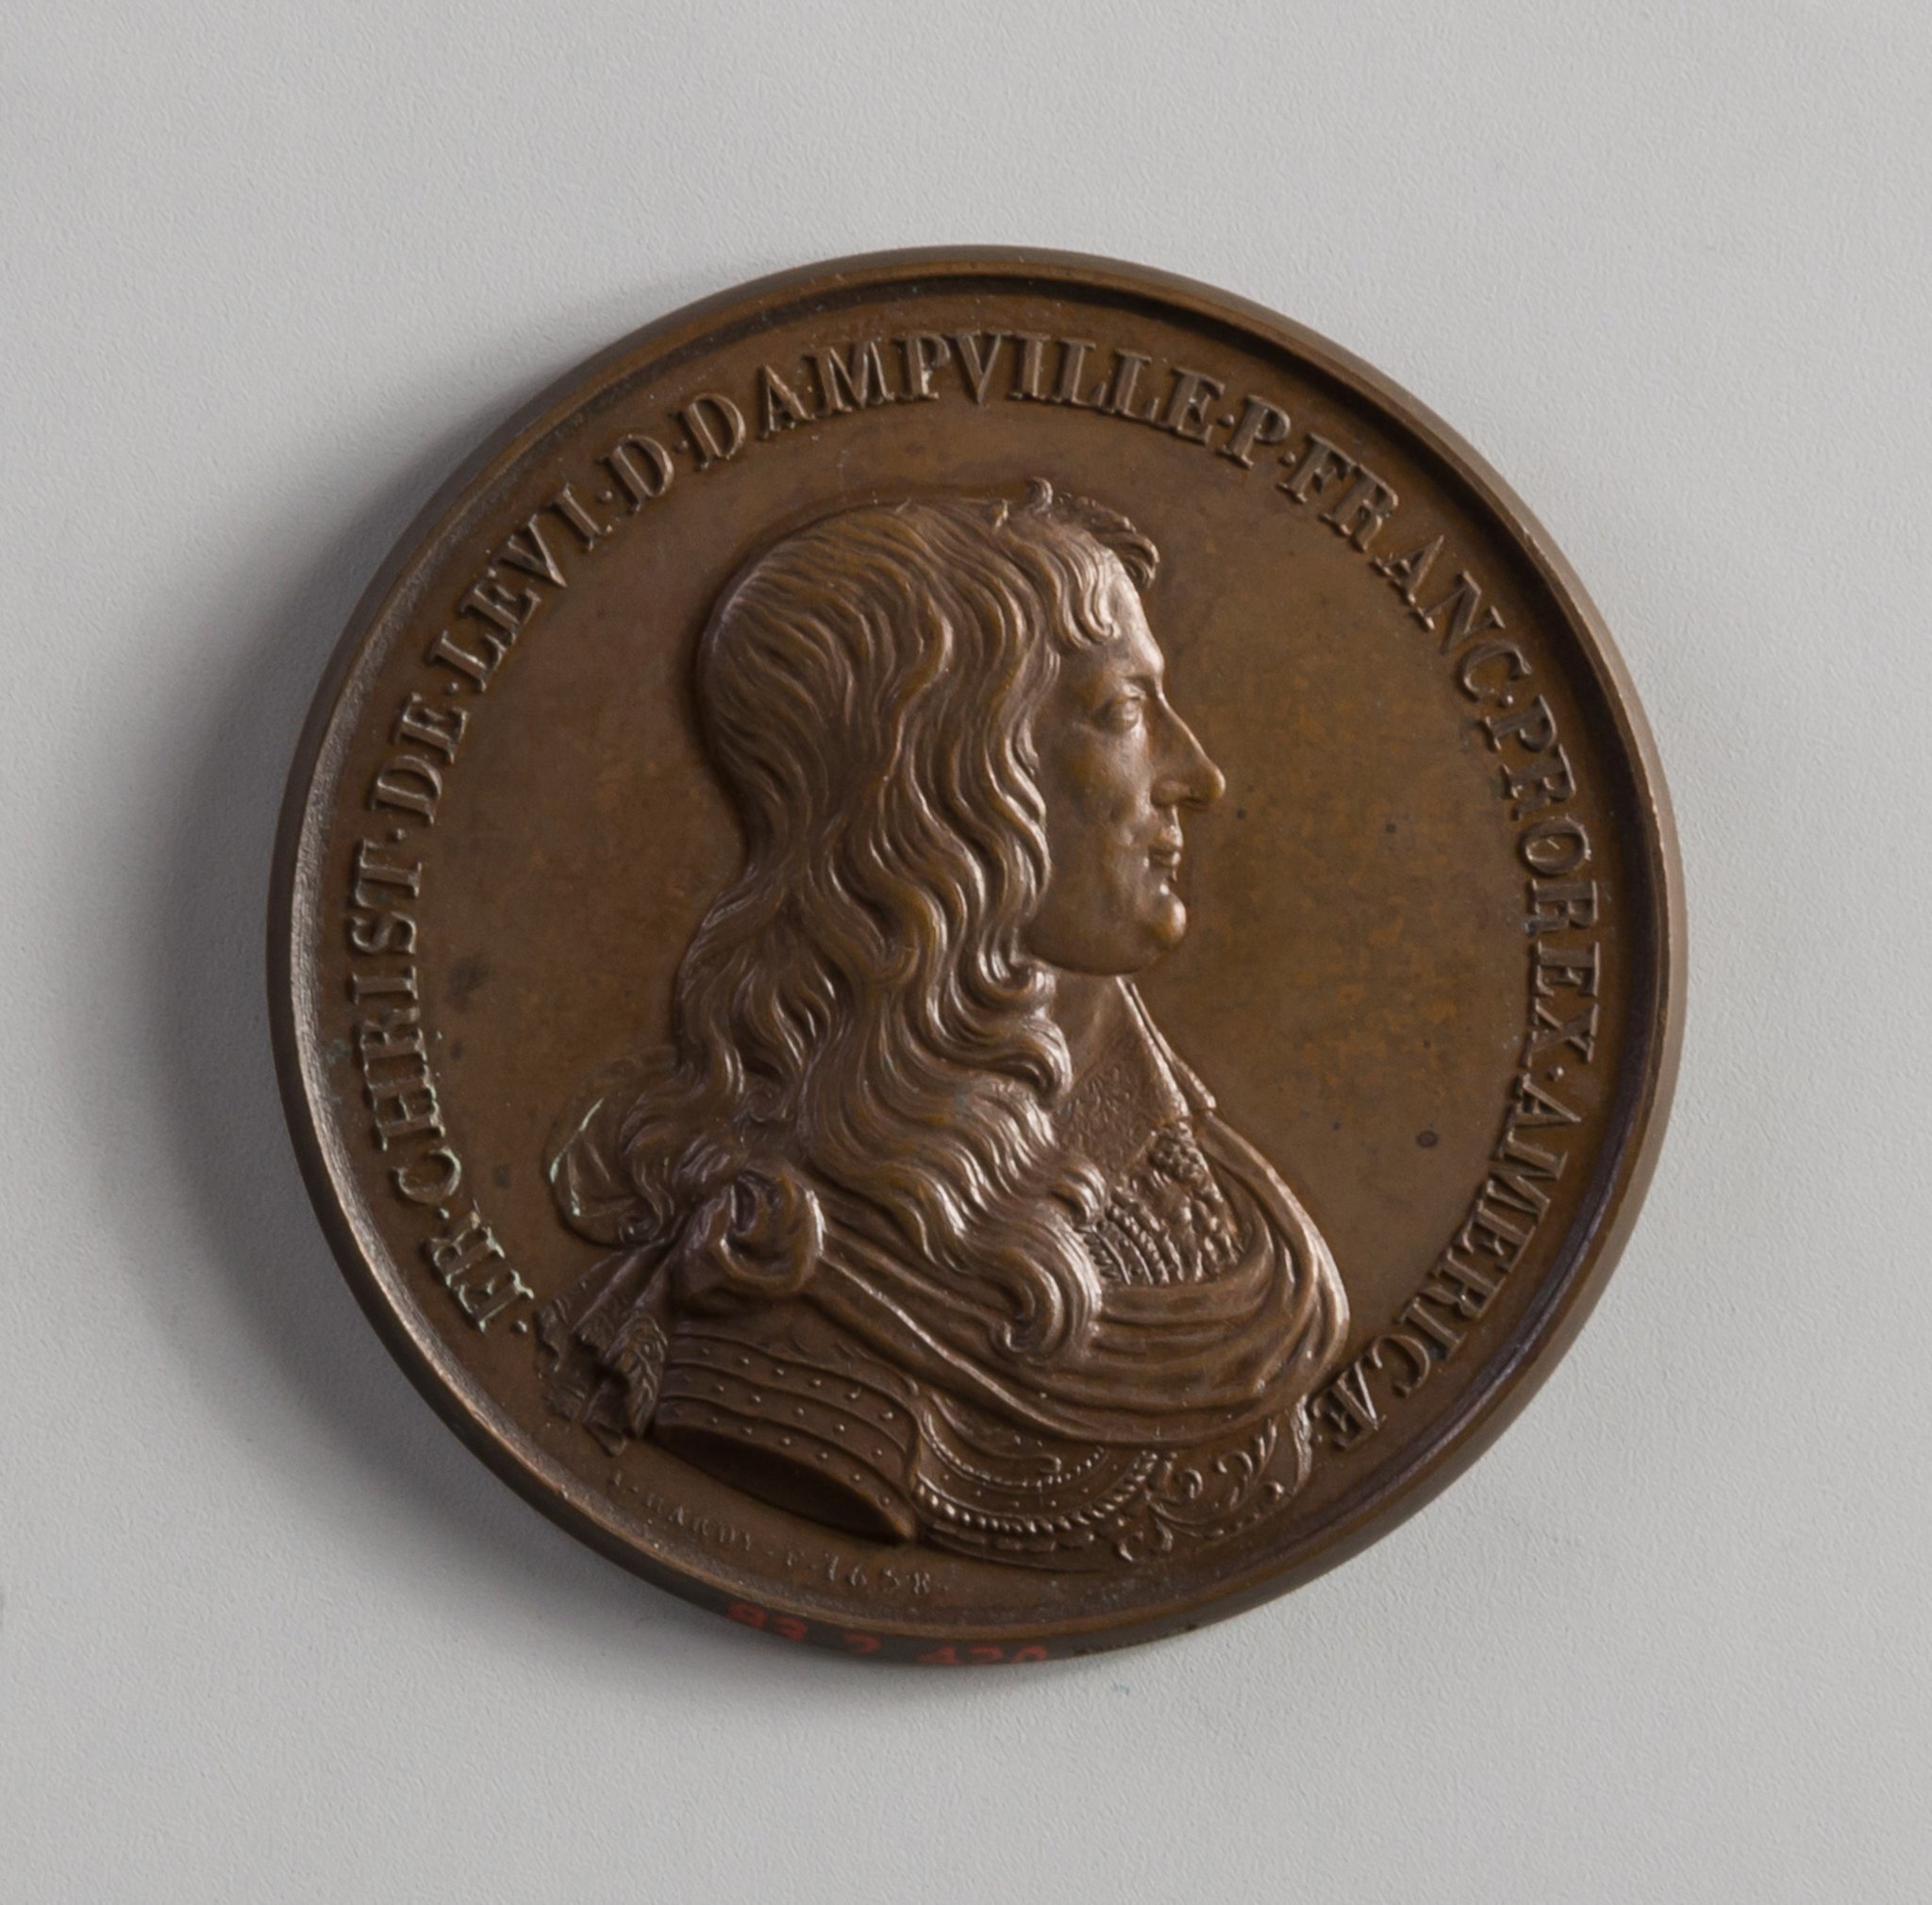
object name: medal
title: Medal of Francis, Duke de Dampville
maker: jean hardy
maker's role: maker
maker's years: 1647-1684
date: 1658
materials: bronze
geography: france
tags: men,profiles